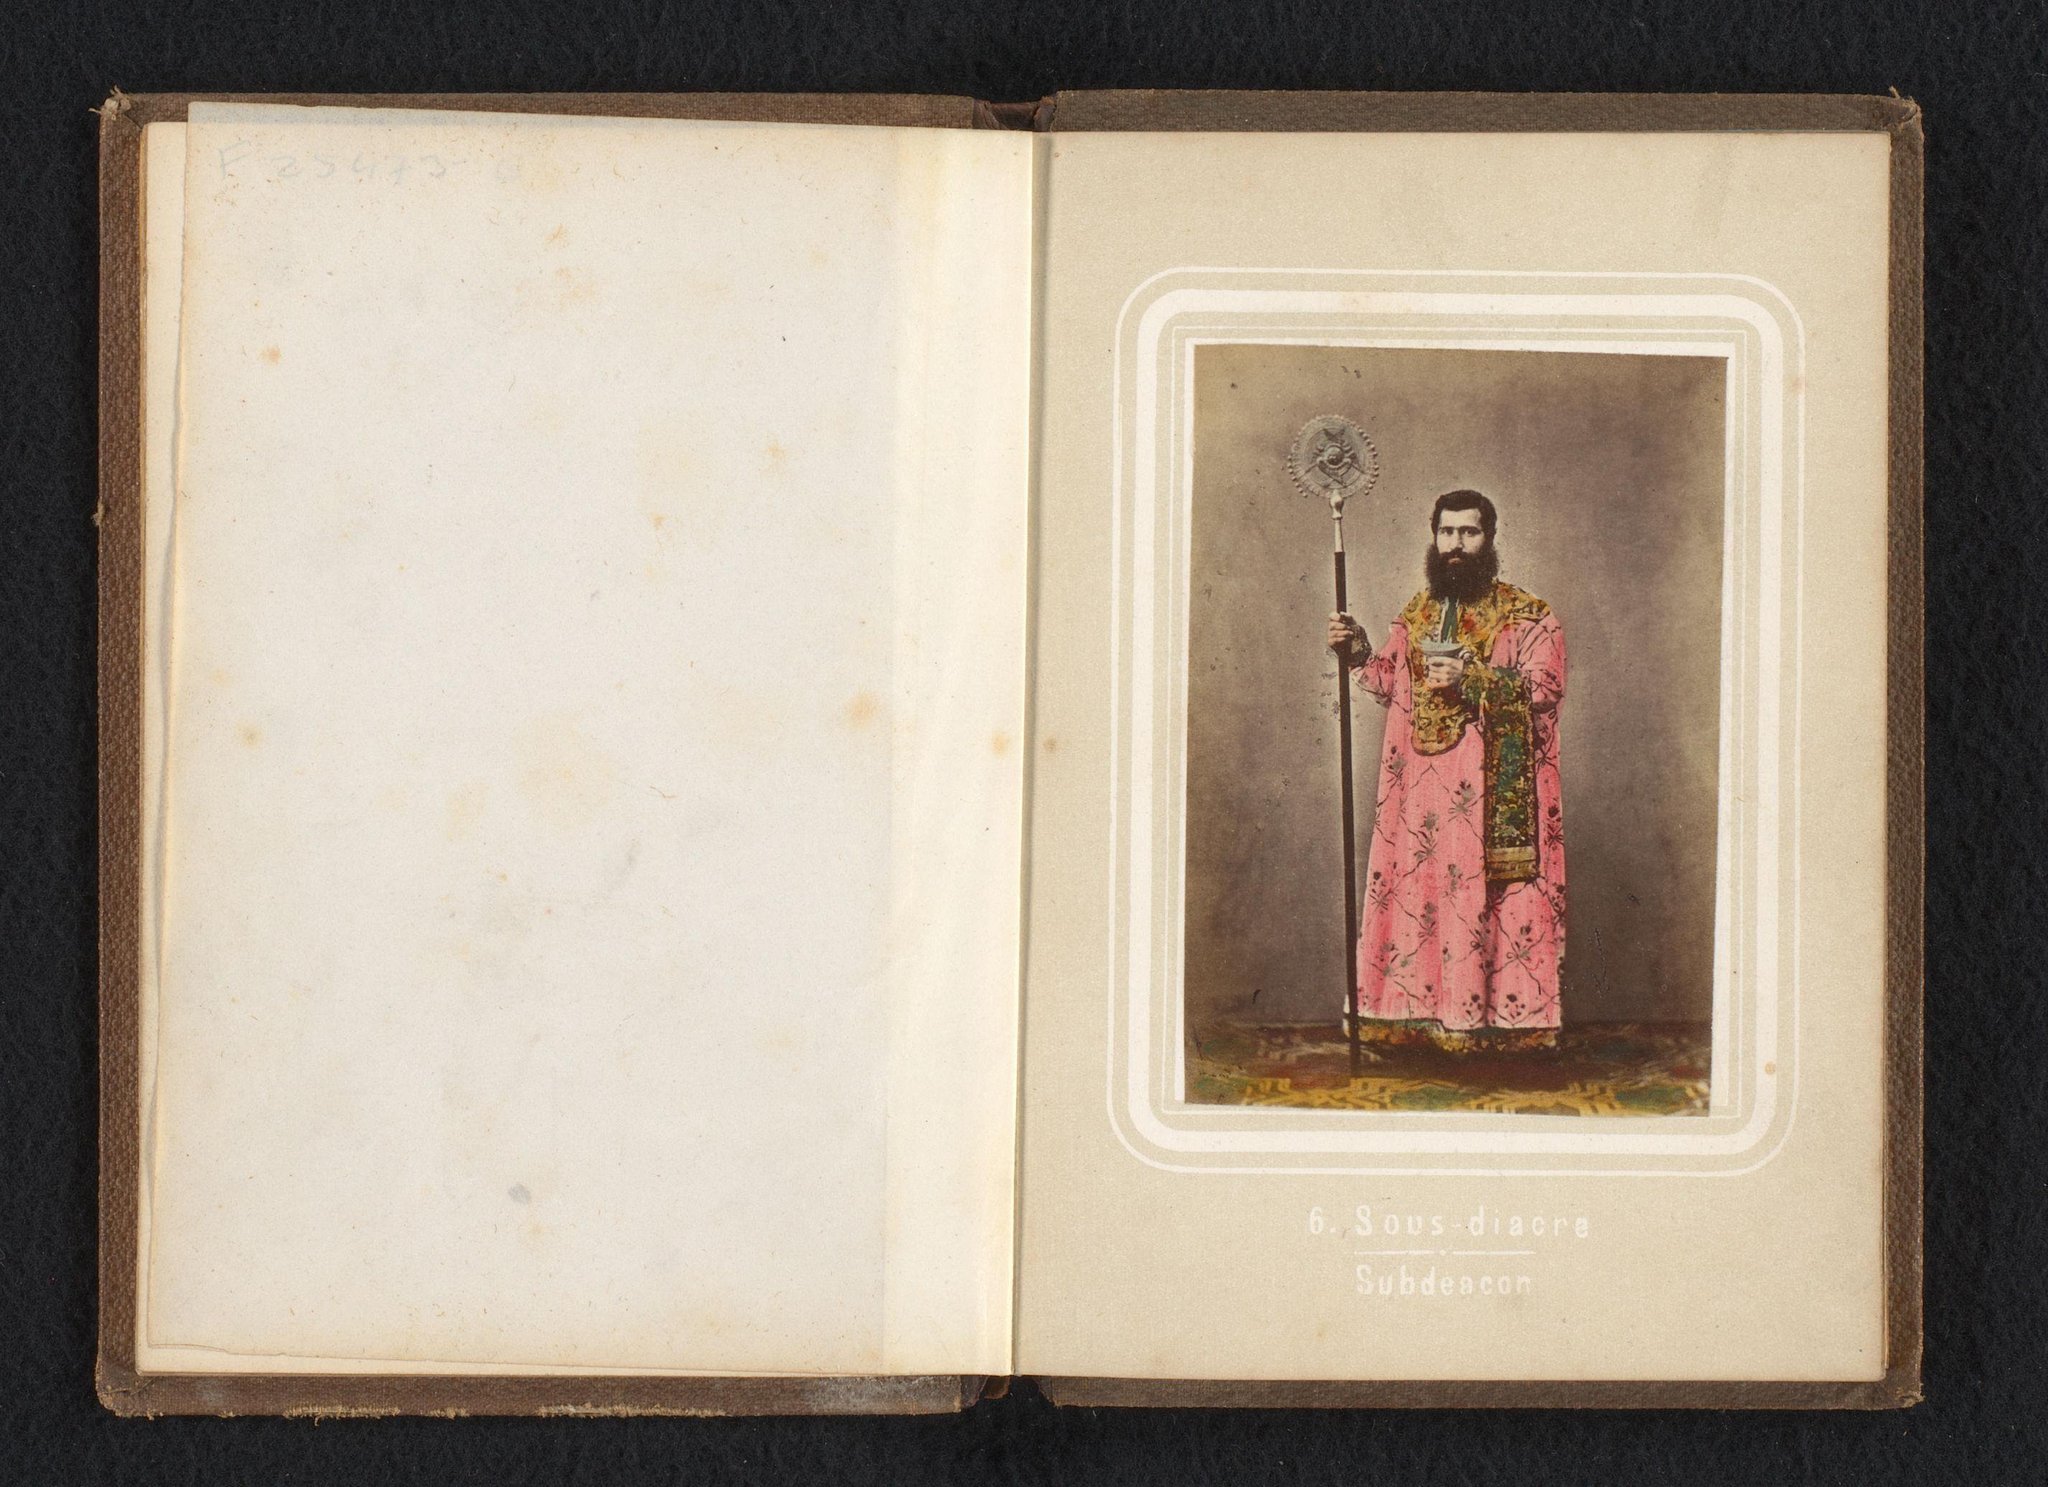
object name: page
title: Sous-diacre / Subdeacon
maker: Anonymous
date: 1870-1890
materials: paper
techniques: albumen print, hand coloring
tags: deacon (roman catholic), anonymous historical person portrayed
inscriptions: number: ‘6.’